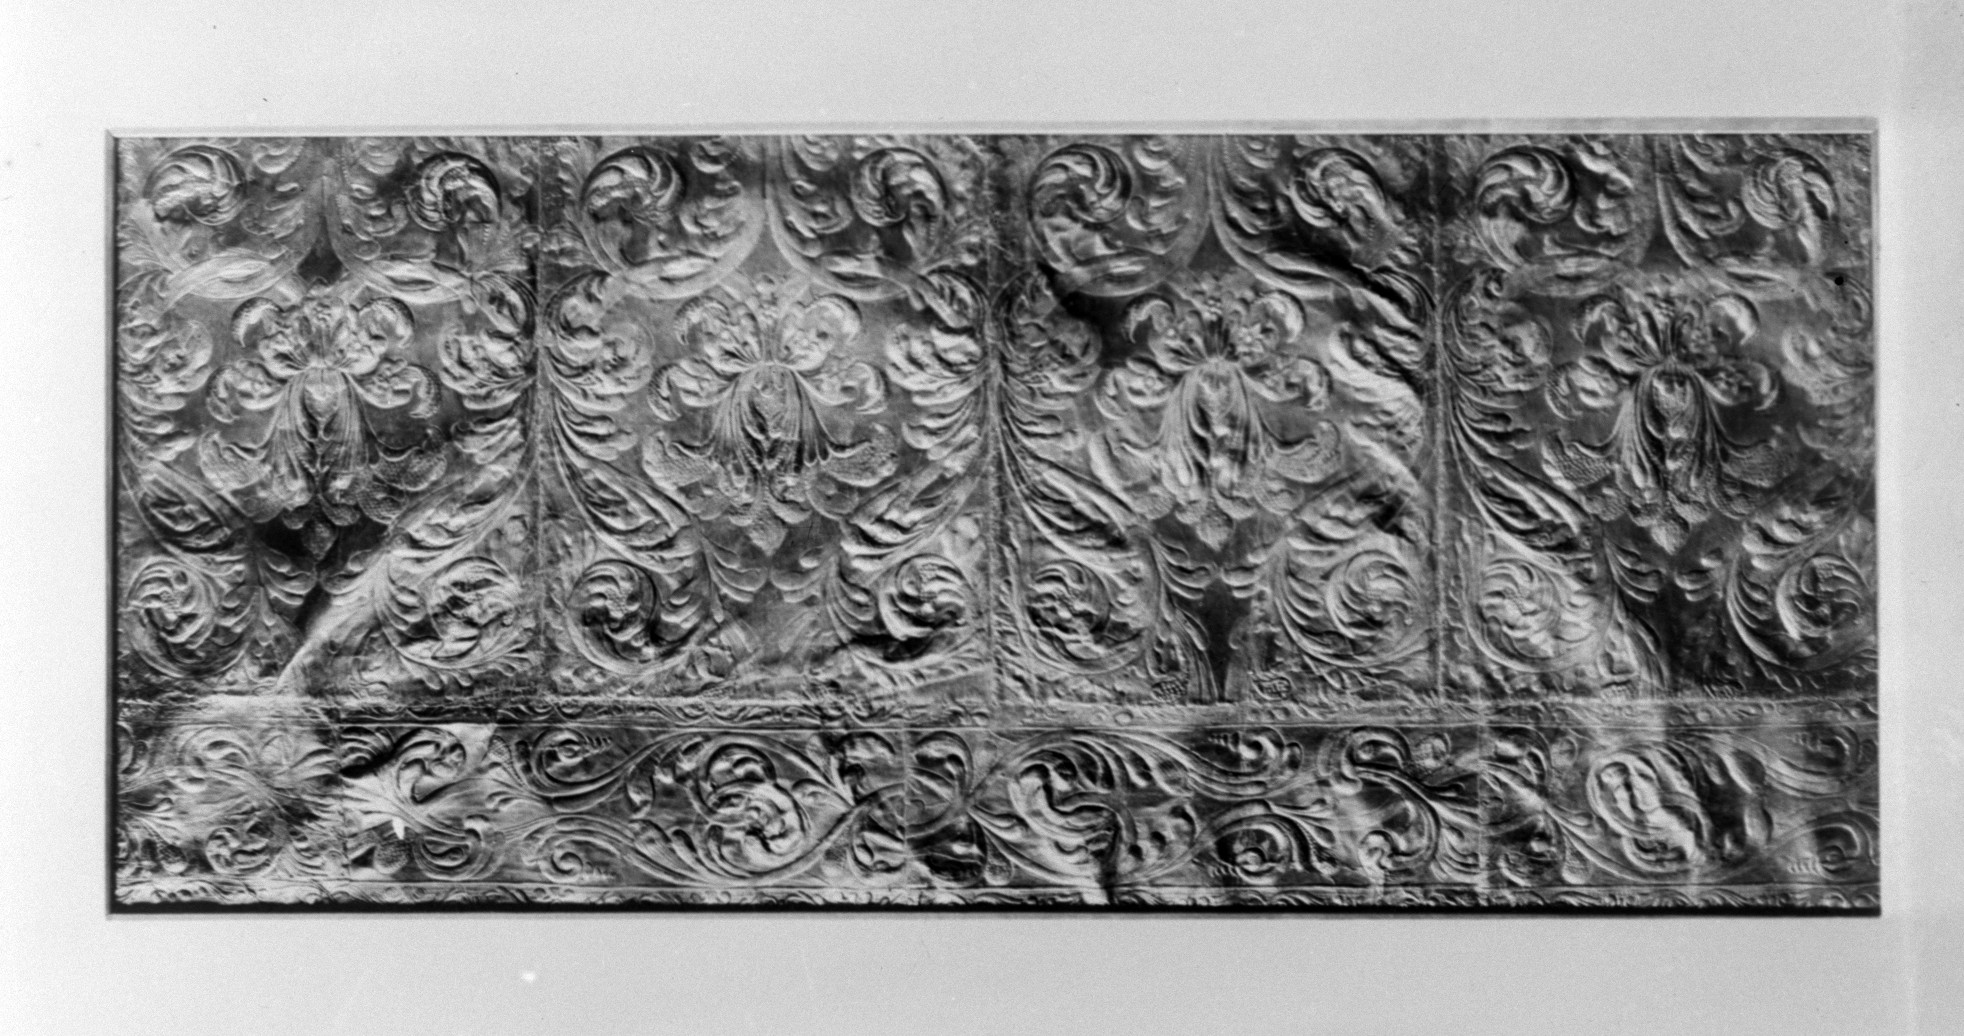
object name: wall hanging fragment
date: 1651-1700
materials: leather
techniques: embossing